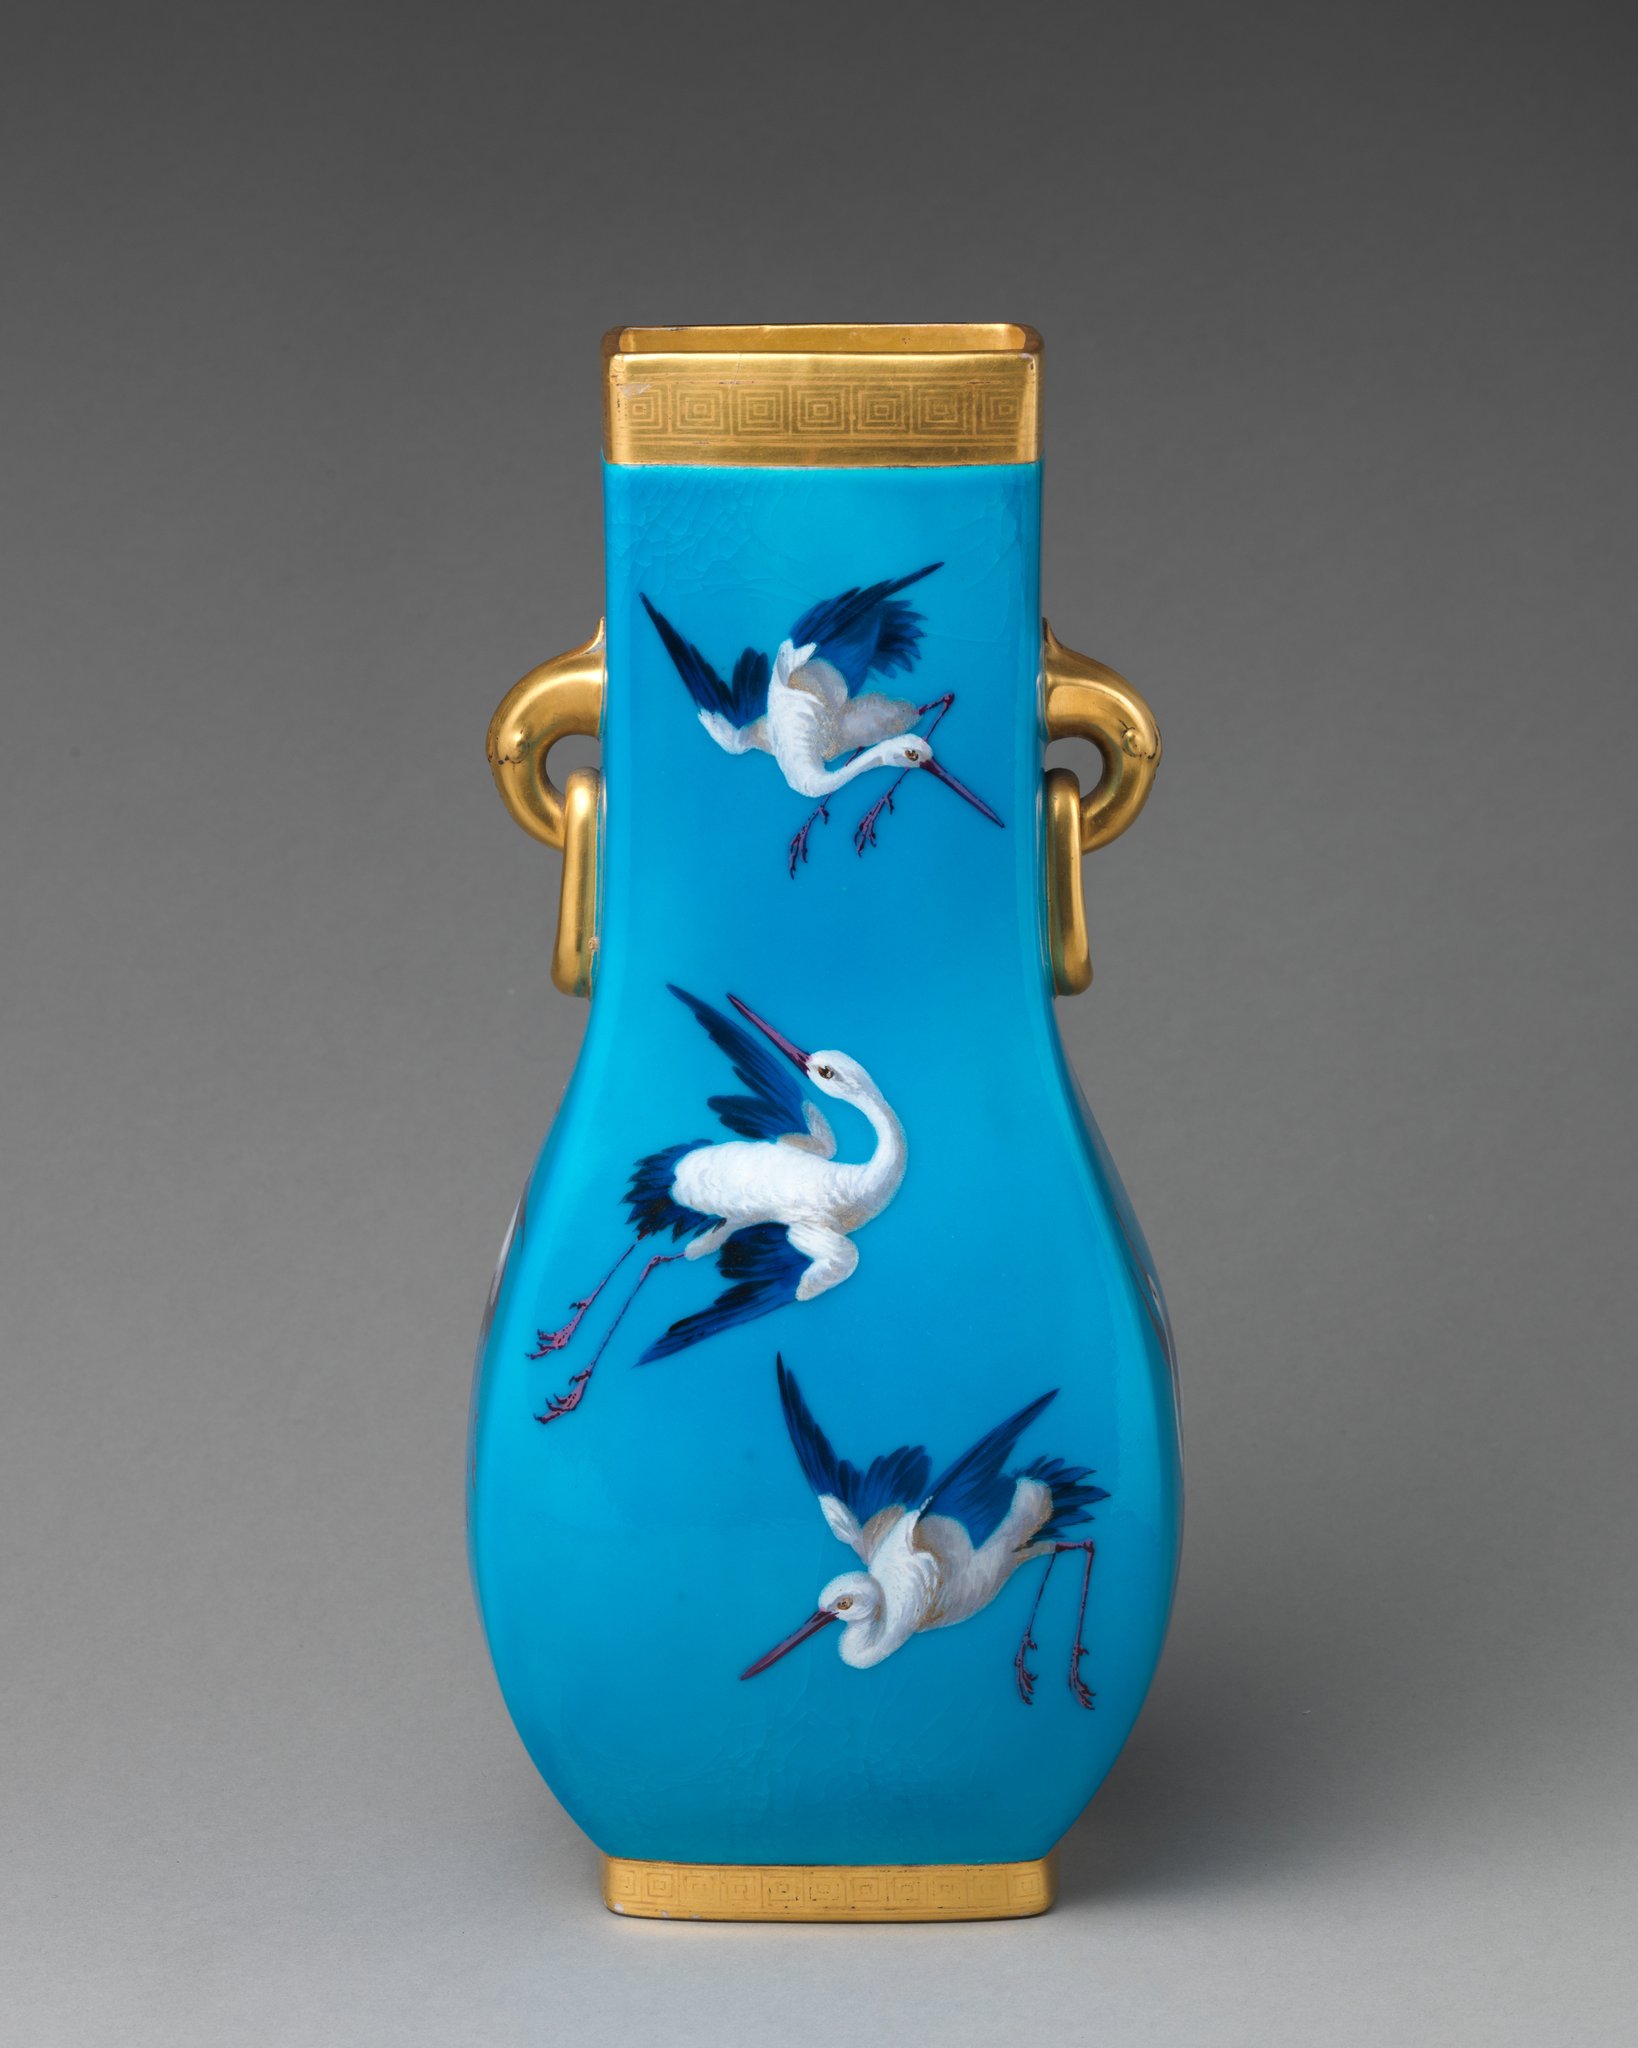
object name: vase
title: Vase with crane motifs and ring handles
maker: minton(s)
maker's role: maker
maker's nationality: british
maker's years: 1793-2001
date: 1873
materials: bone china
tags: cranes